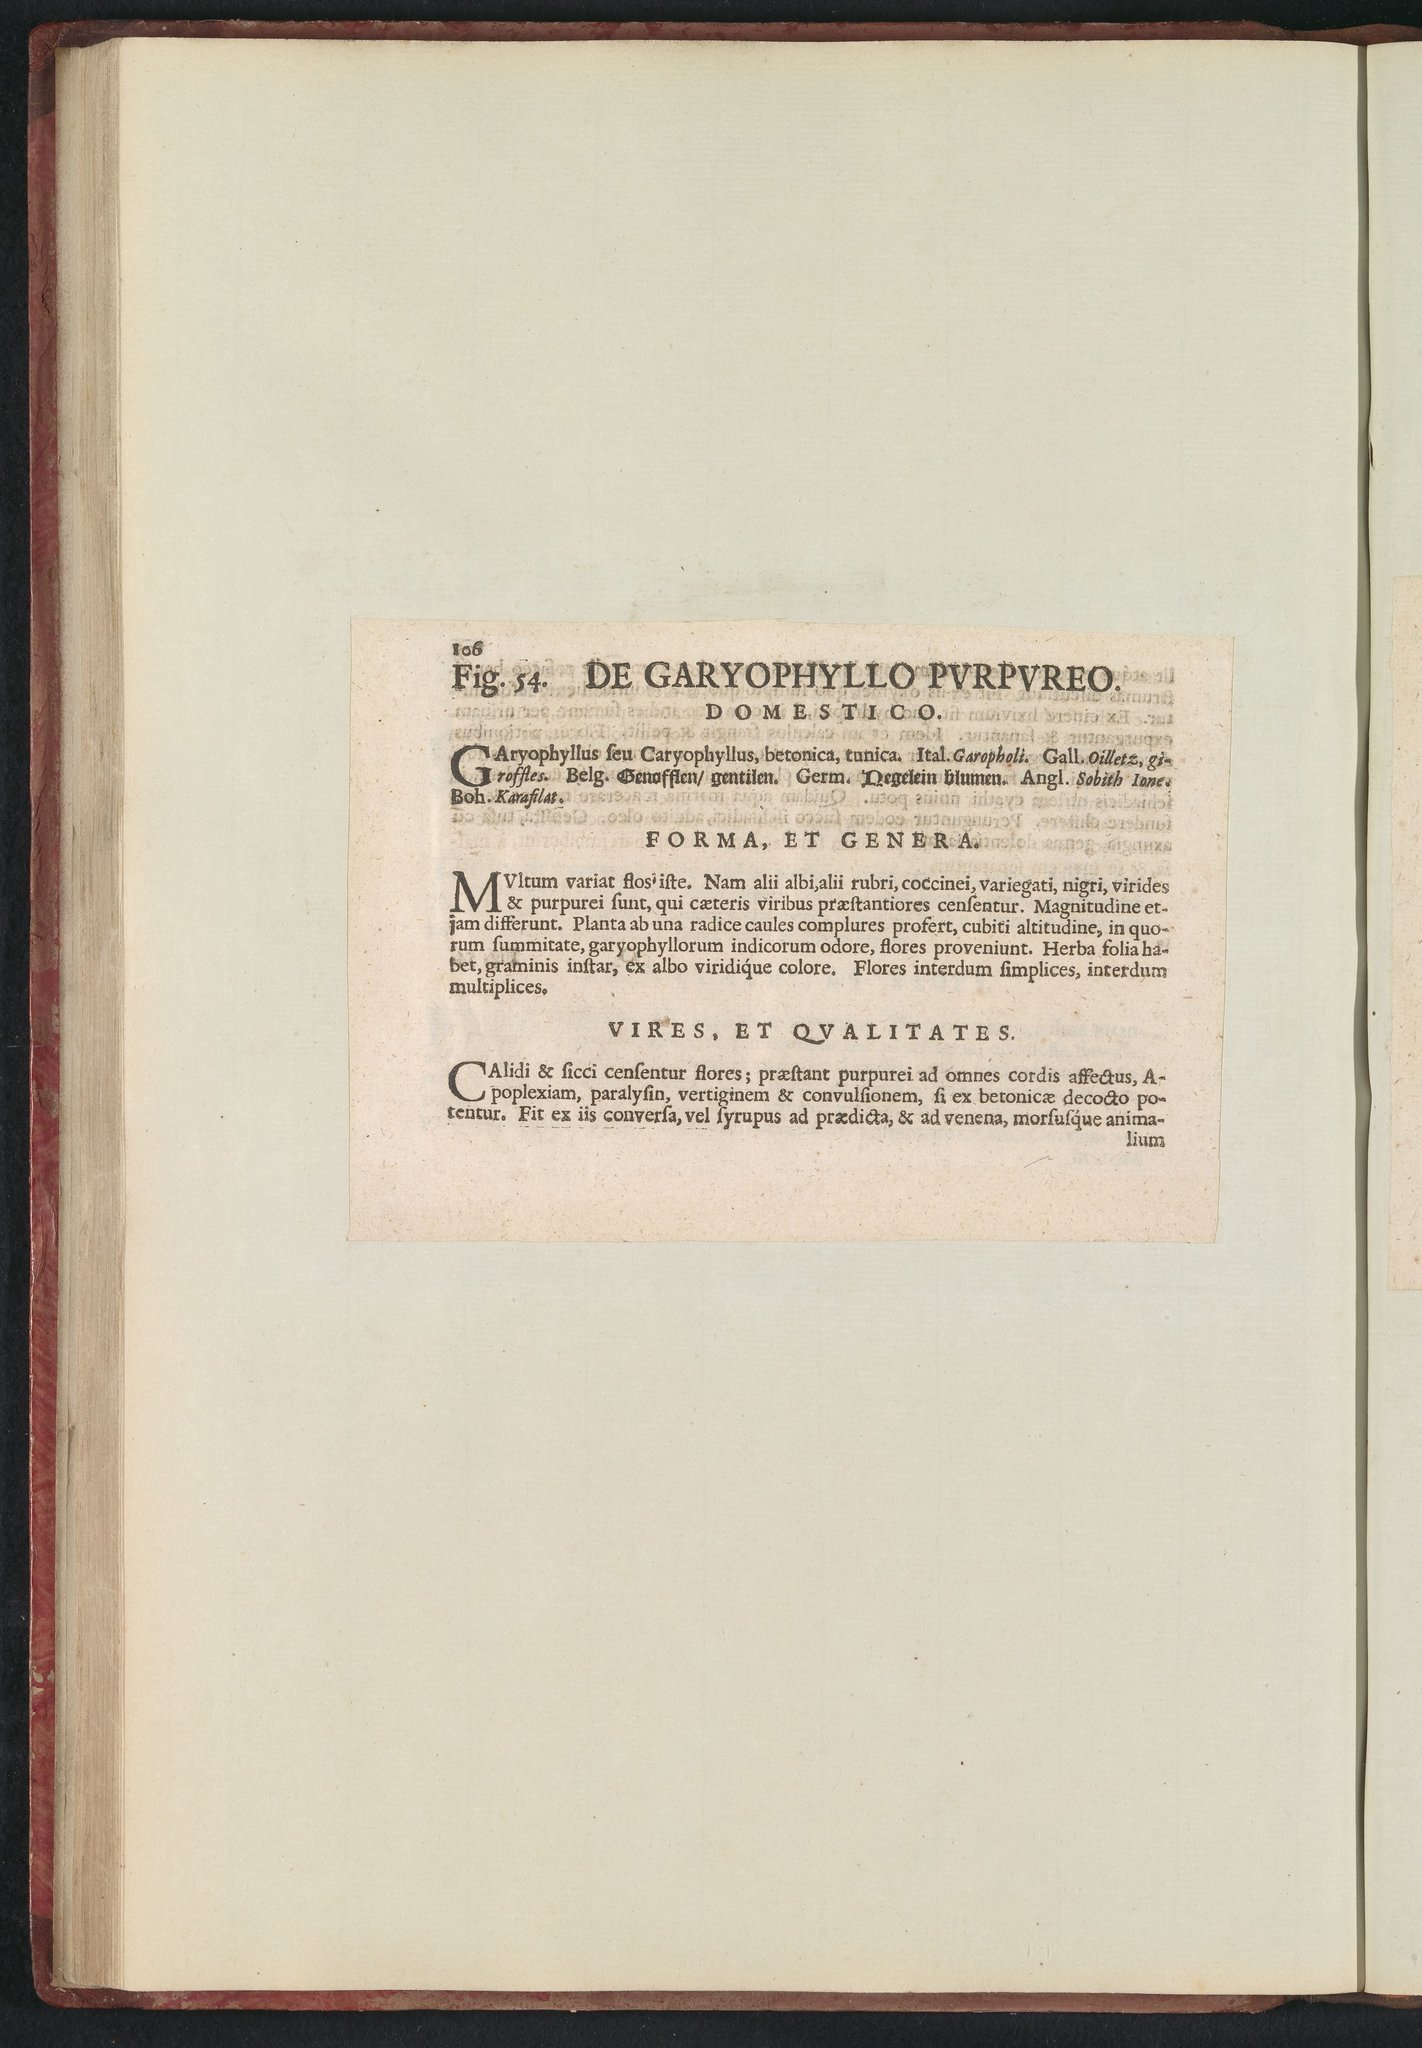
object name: text sheet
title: Fig. 54 'De Garyophyllo Pvrpvreo' in De Boodts herbarium van 1640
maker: anselmus boëtius de boodt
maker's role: draughtsman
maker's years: 1550-1632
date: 1640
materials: ink, paper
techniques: letterpress printing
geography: bruges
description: Beschrijving bij Fig. 54 op p. 106 in: Anselmi Boëtii de Boot I.C. Brugensis & Rodolphi II. Imp. Roman. medici a cubiculis Florum, Herbarum, ac fructuum selectiorum icones, & vires pleraeque hactenus ignotæ. Onderdeel van het album met bladen en platen uit De Boodts herbarium van 1640. Het twaalfde van twaalf albums met aquarellen van dieren, vogels en planten bekend rond 1600, gemaakt in opdracht van keizer Rudolf II.